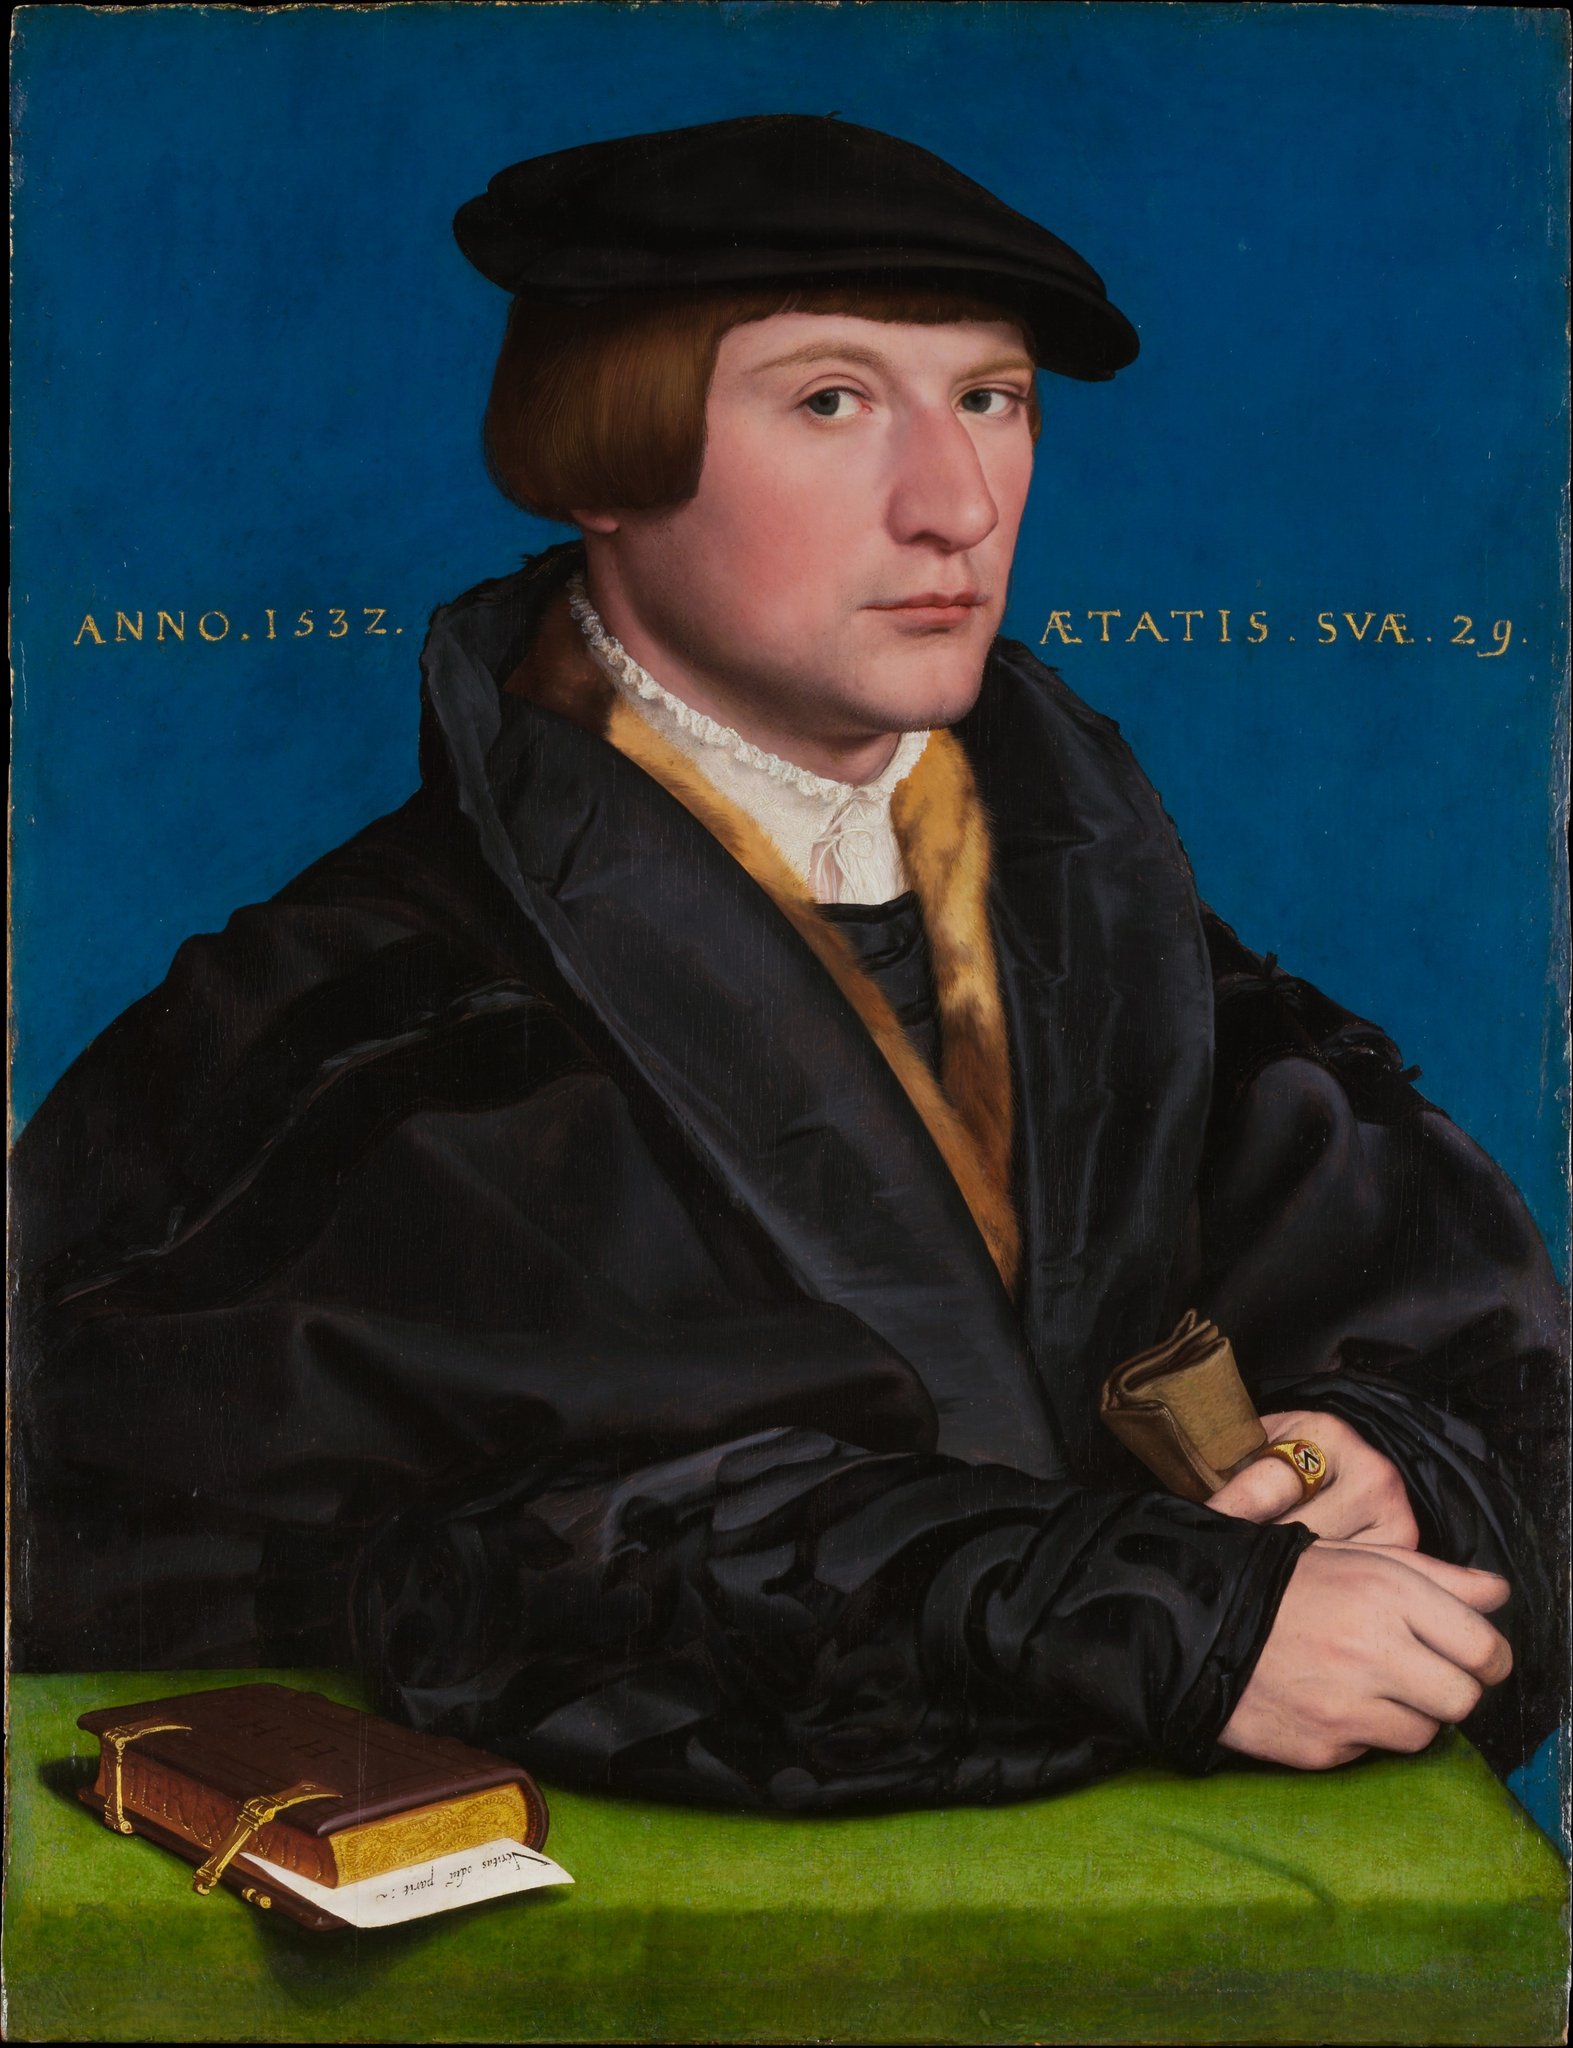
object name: painting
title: Hermann von Wedigh III (died 1560)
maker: hans holbein the younger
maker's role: artist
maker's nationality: german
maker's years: 1497-1543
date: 1532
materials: gold, wood, oil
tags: men,portraits,latin